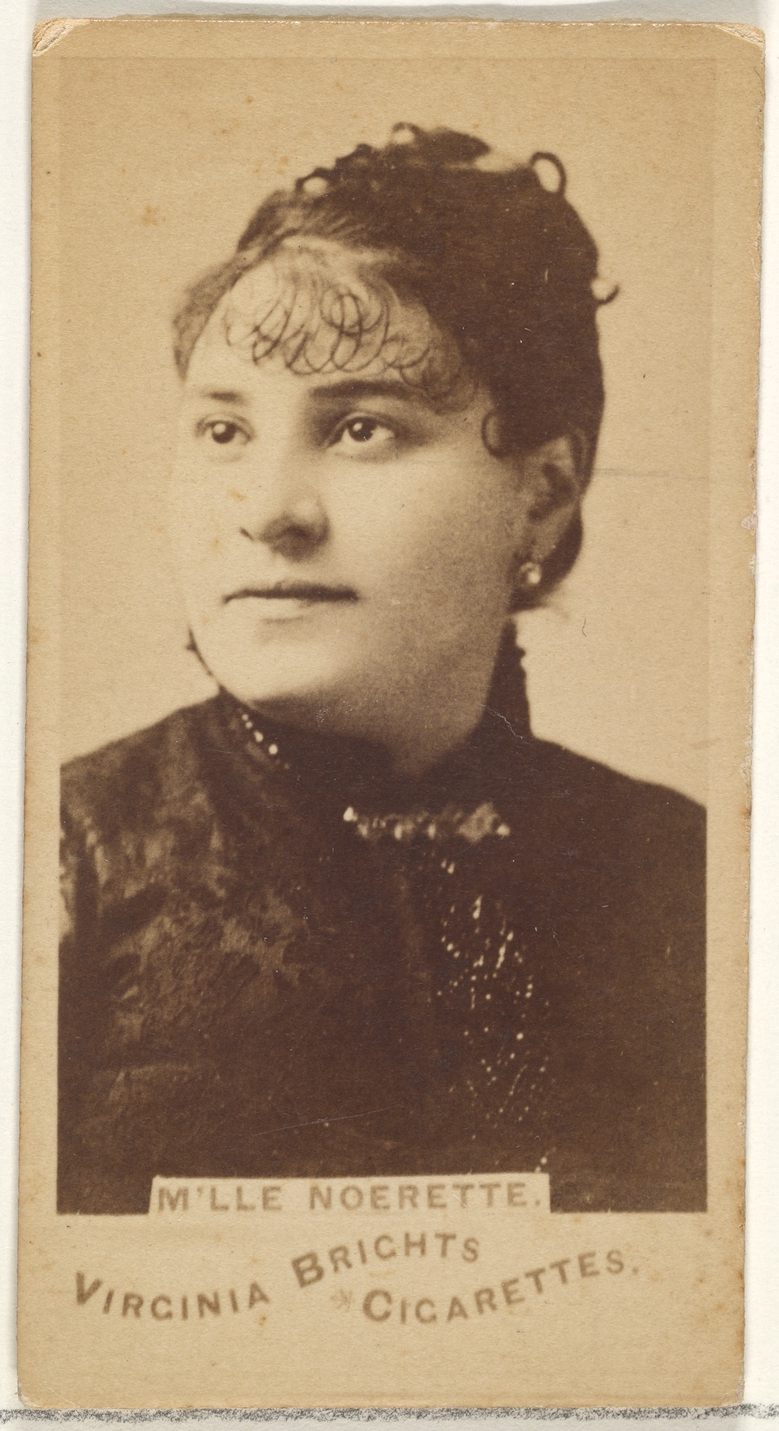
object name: photograph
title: M'lle Noerette, from the Actors and Actresses series (N45, Type 1) for Virginia Brights Cigarettes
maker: allen & ginter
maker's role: publisher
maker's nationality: american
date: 1888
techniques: albumen silver print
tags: portraits,women,actresses